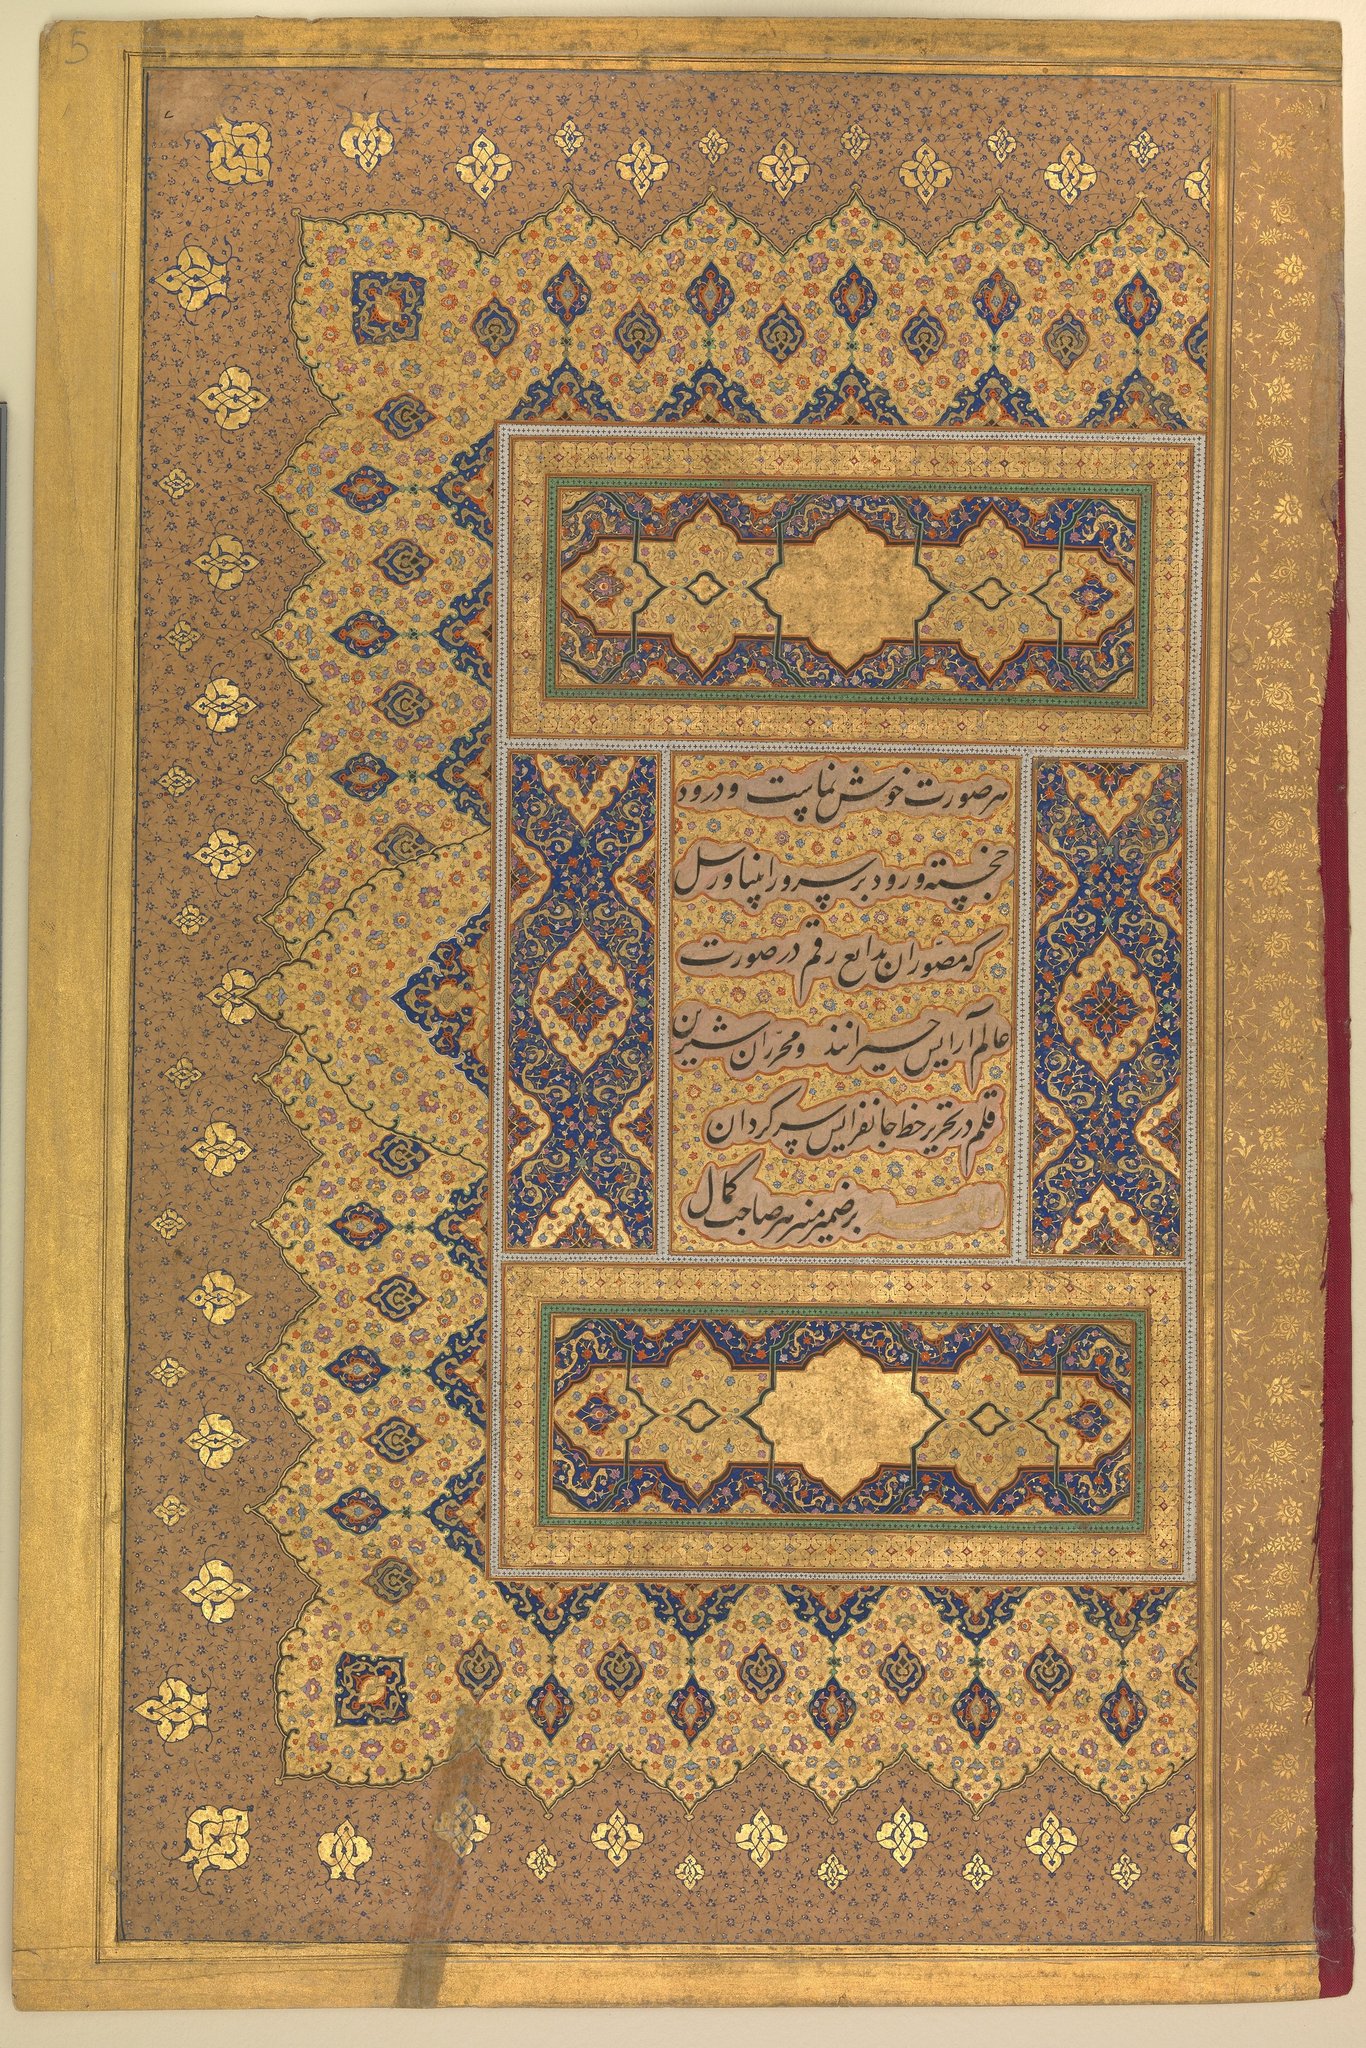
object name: album leaf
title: "Unwan", Folio from the Shah Jahan Album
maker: mir 'ali haravi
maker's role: calligrapher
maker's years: 1525-1575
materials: gold, ink, paper, watercolor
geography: india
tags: persian,calligraphy